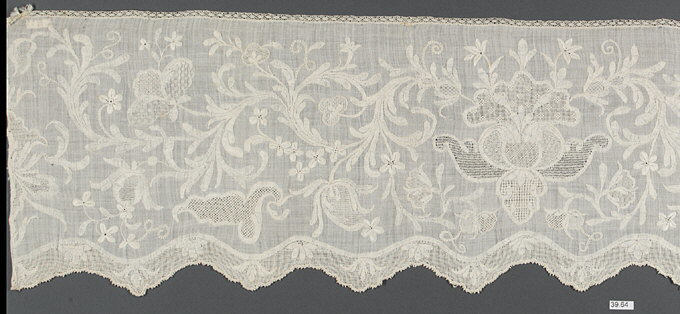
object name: border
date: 1701-1800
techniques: embroidery